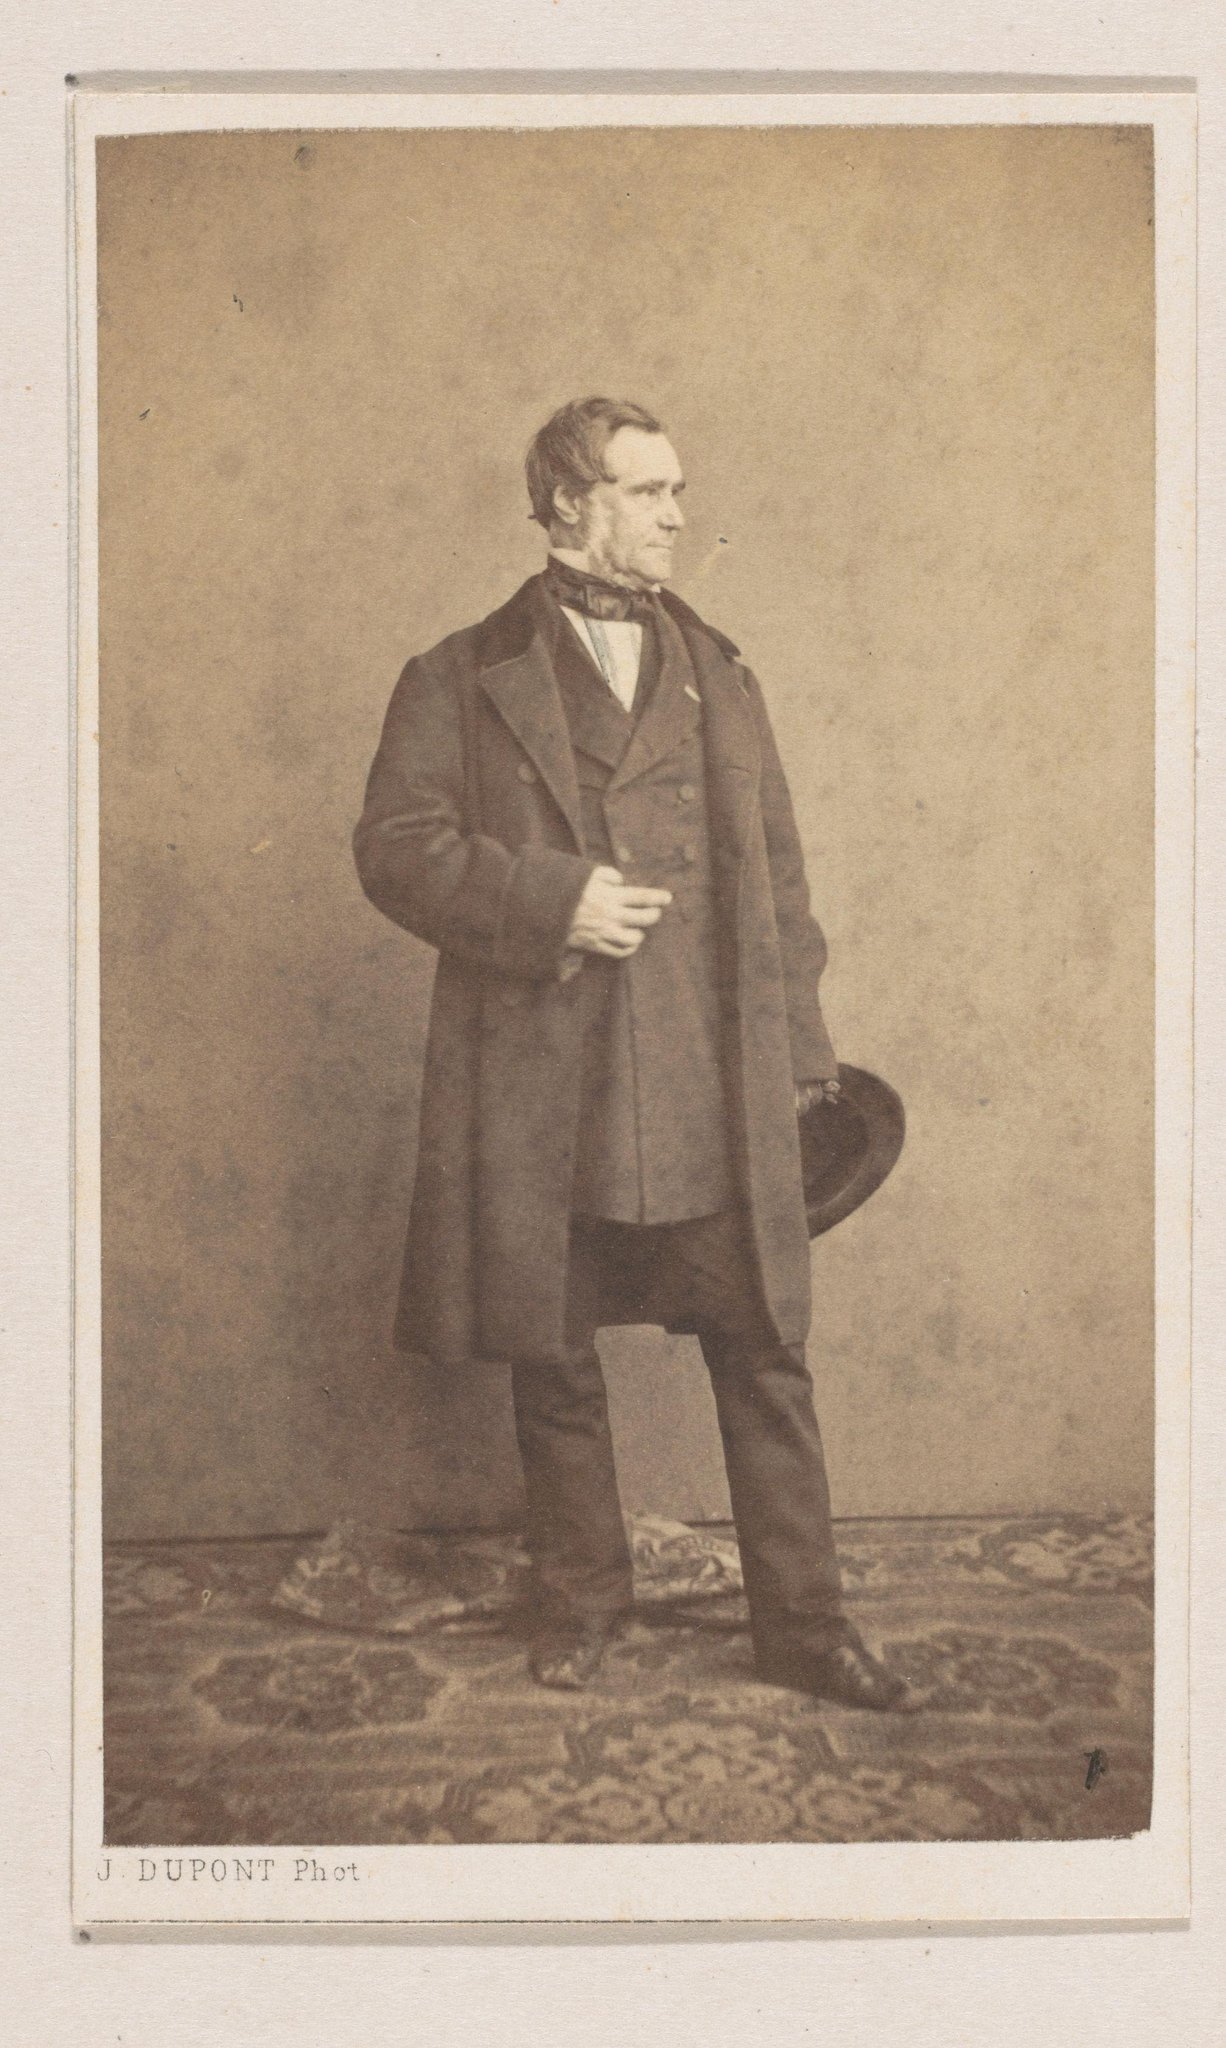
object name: photograph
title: L'École d'Anvers. Portraits biographies cartes de visite. Collection Dupont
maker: joseph dupont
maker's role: fotograaf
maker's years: 1818-1901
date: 1861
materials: cardboard, paper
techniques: albumen print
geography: antwerp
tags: antwerp, brussels, print maker, draughtsman, antoon van ijsendijck, historical persons, portrait, self-portrait of painter, portrait, self-portrait of artist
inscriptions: inscription: ‘v. Ysendyck’, inscription: ‘ETABLISSEMENT PHOTOGRAPHIQUE/ de/ J. DUPONT/ Place de Meir 32/ ANVERS/ Maison fondée en 1853’